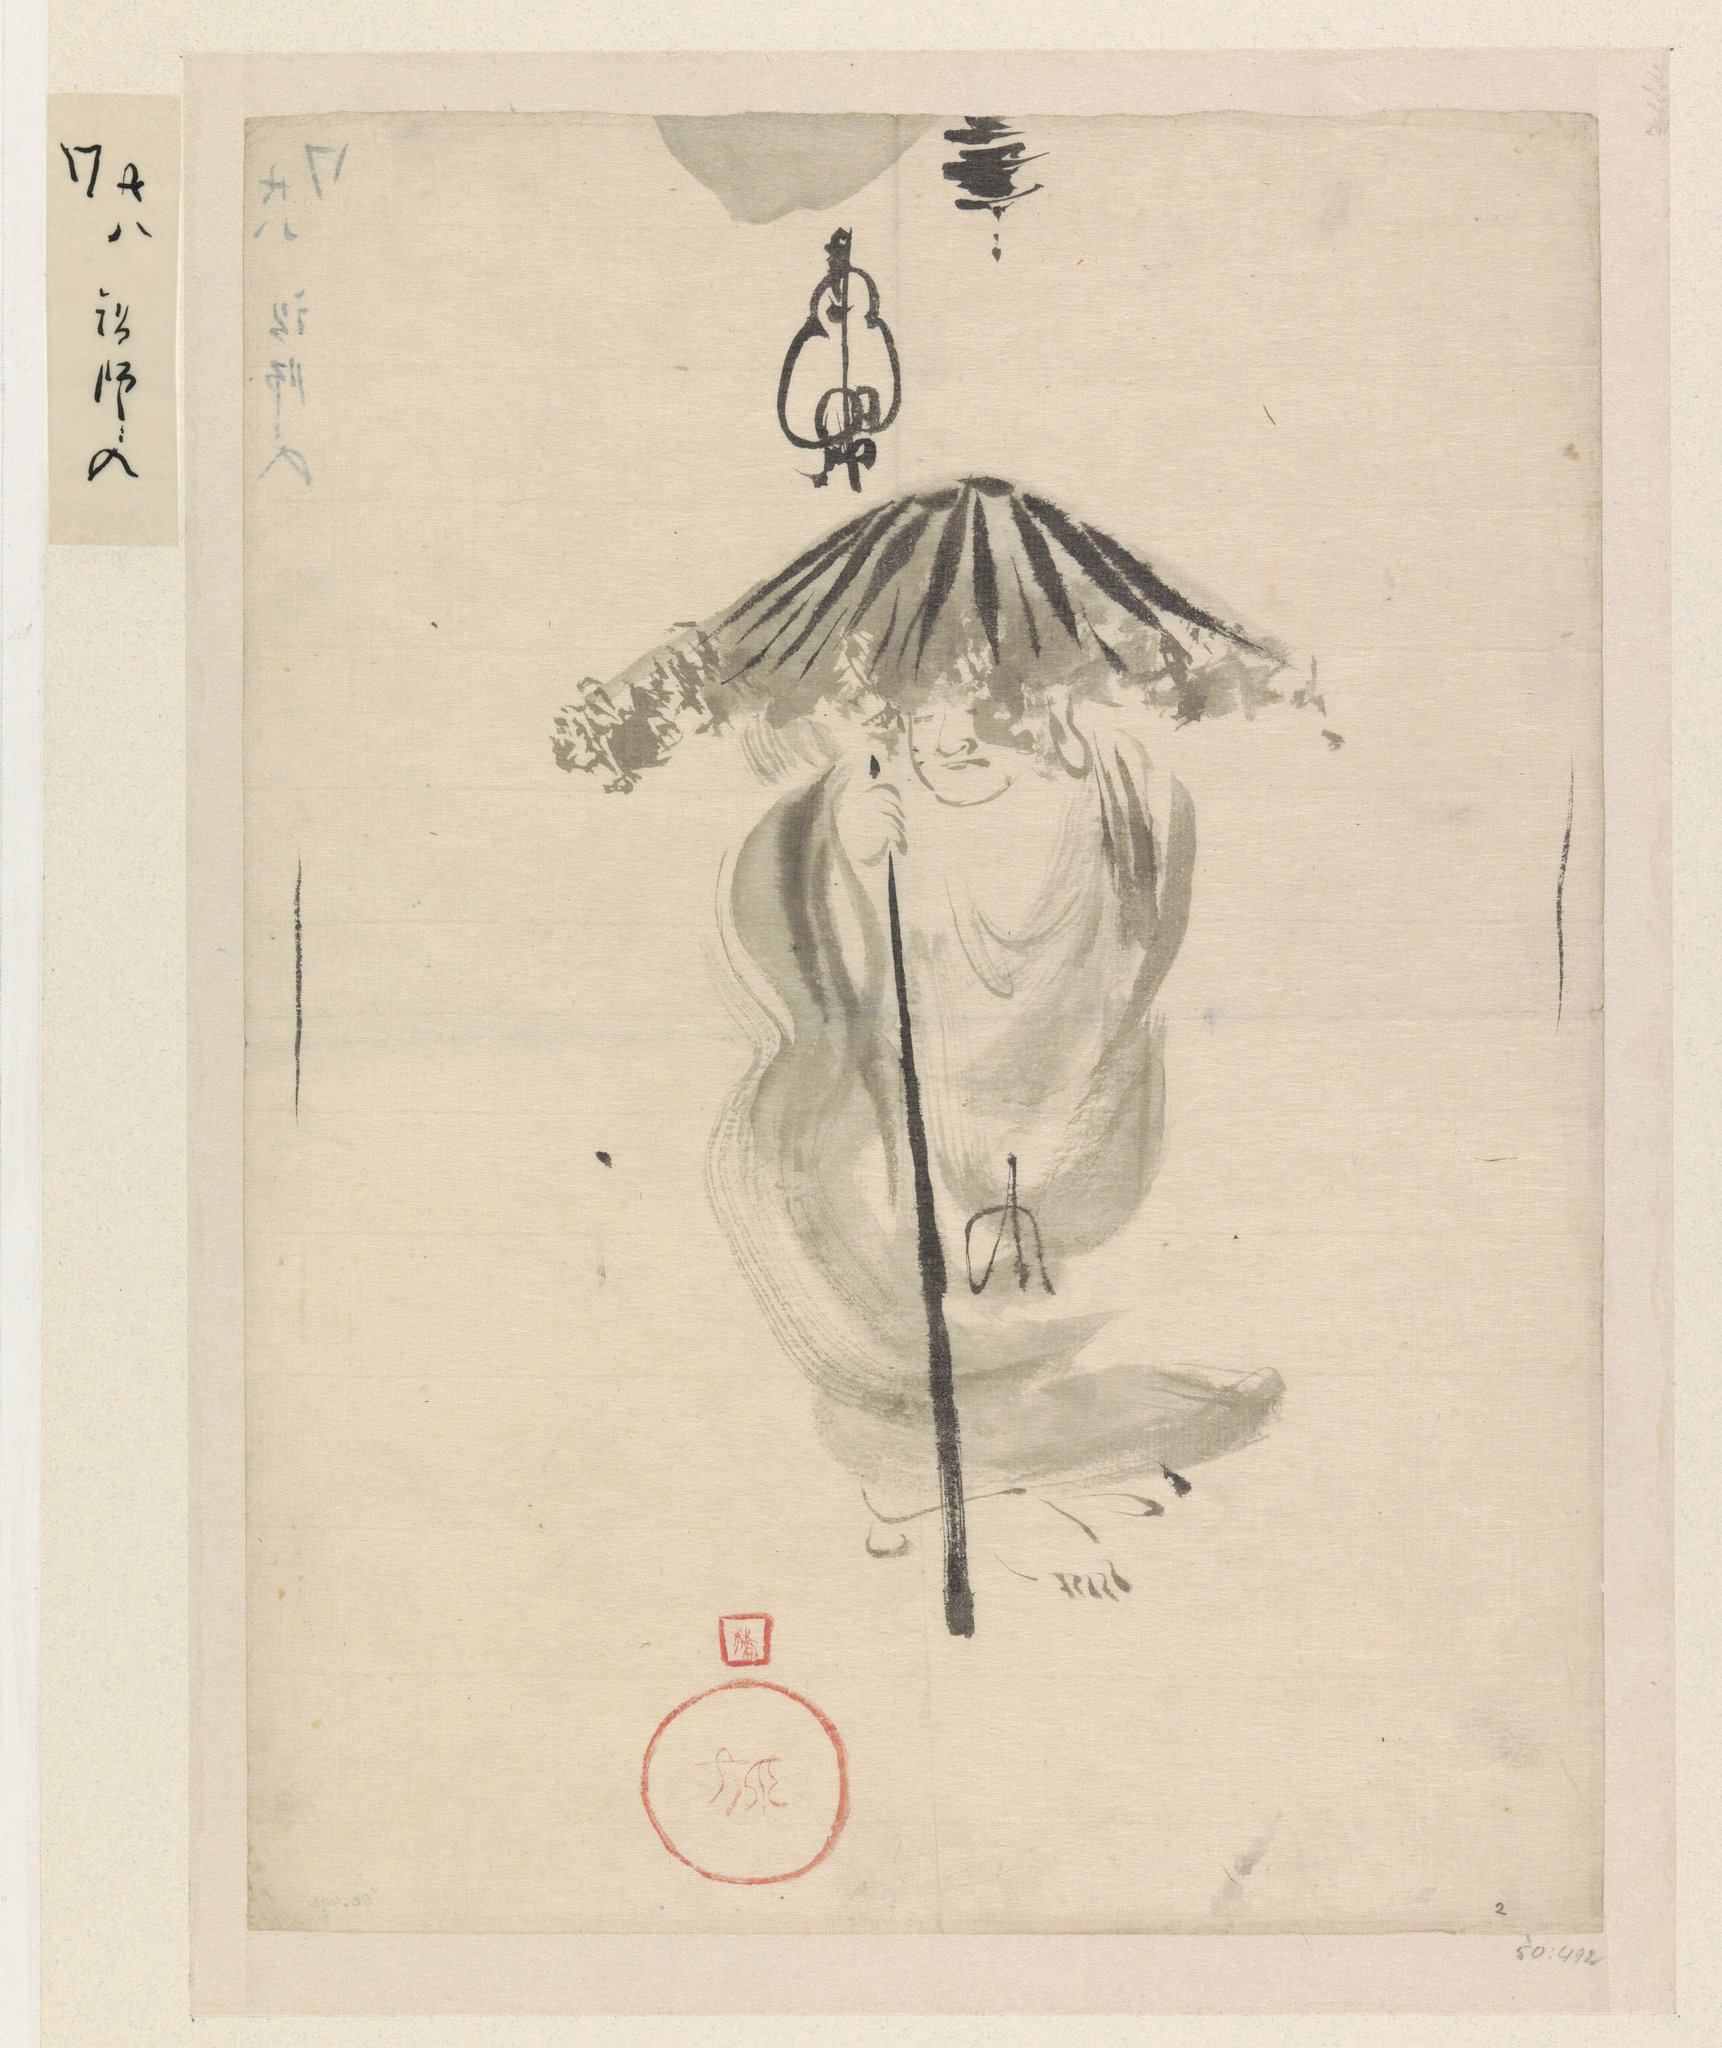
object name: drawing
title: Wijsgeer onder parasol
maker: ichirakasai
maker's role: draughtsman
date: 1700-1900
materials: paper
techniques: brush